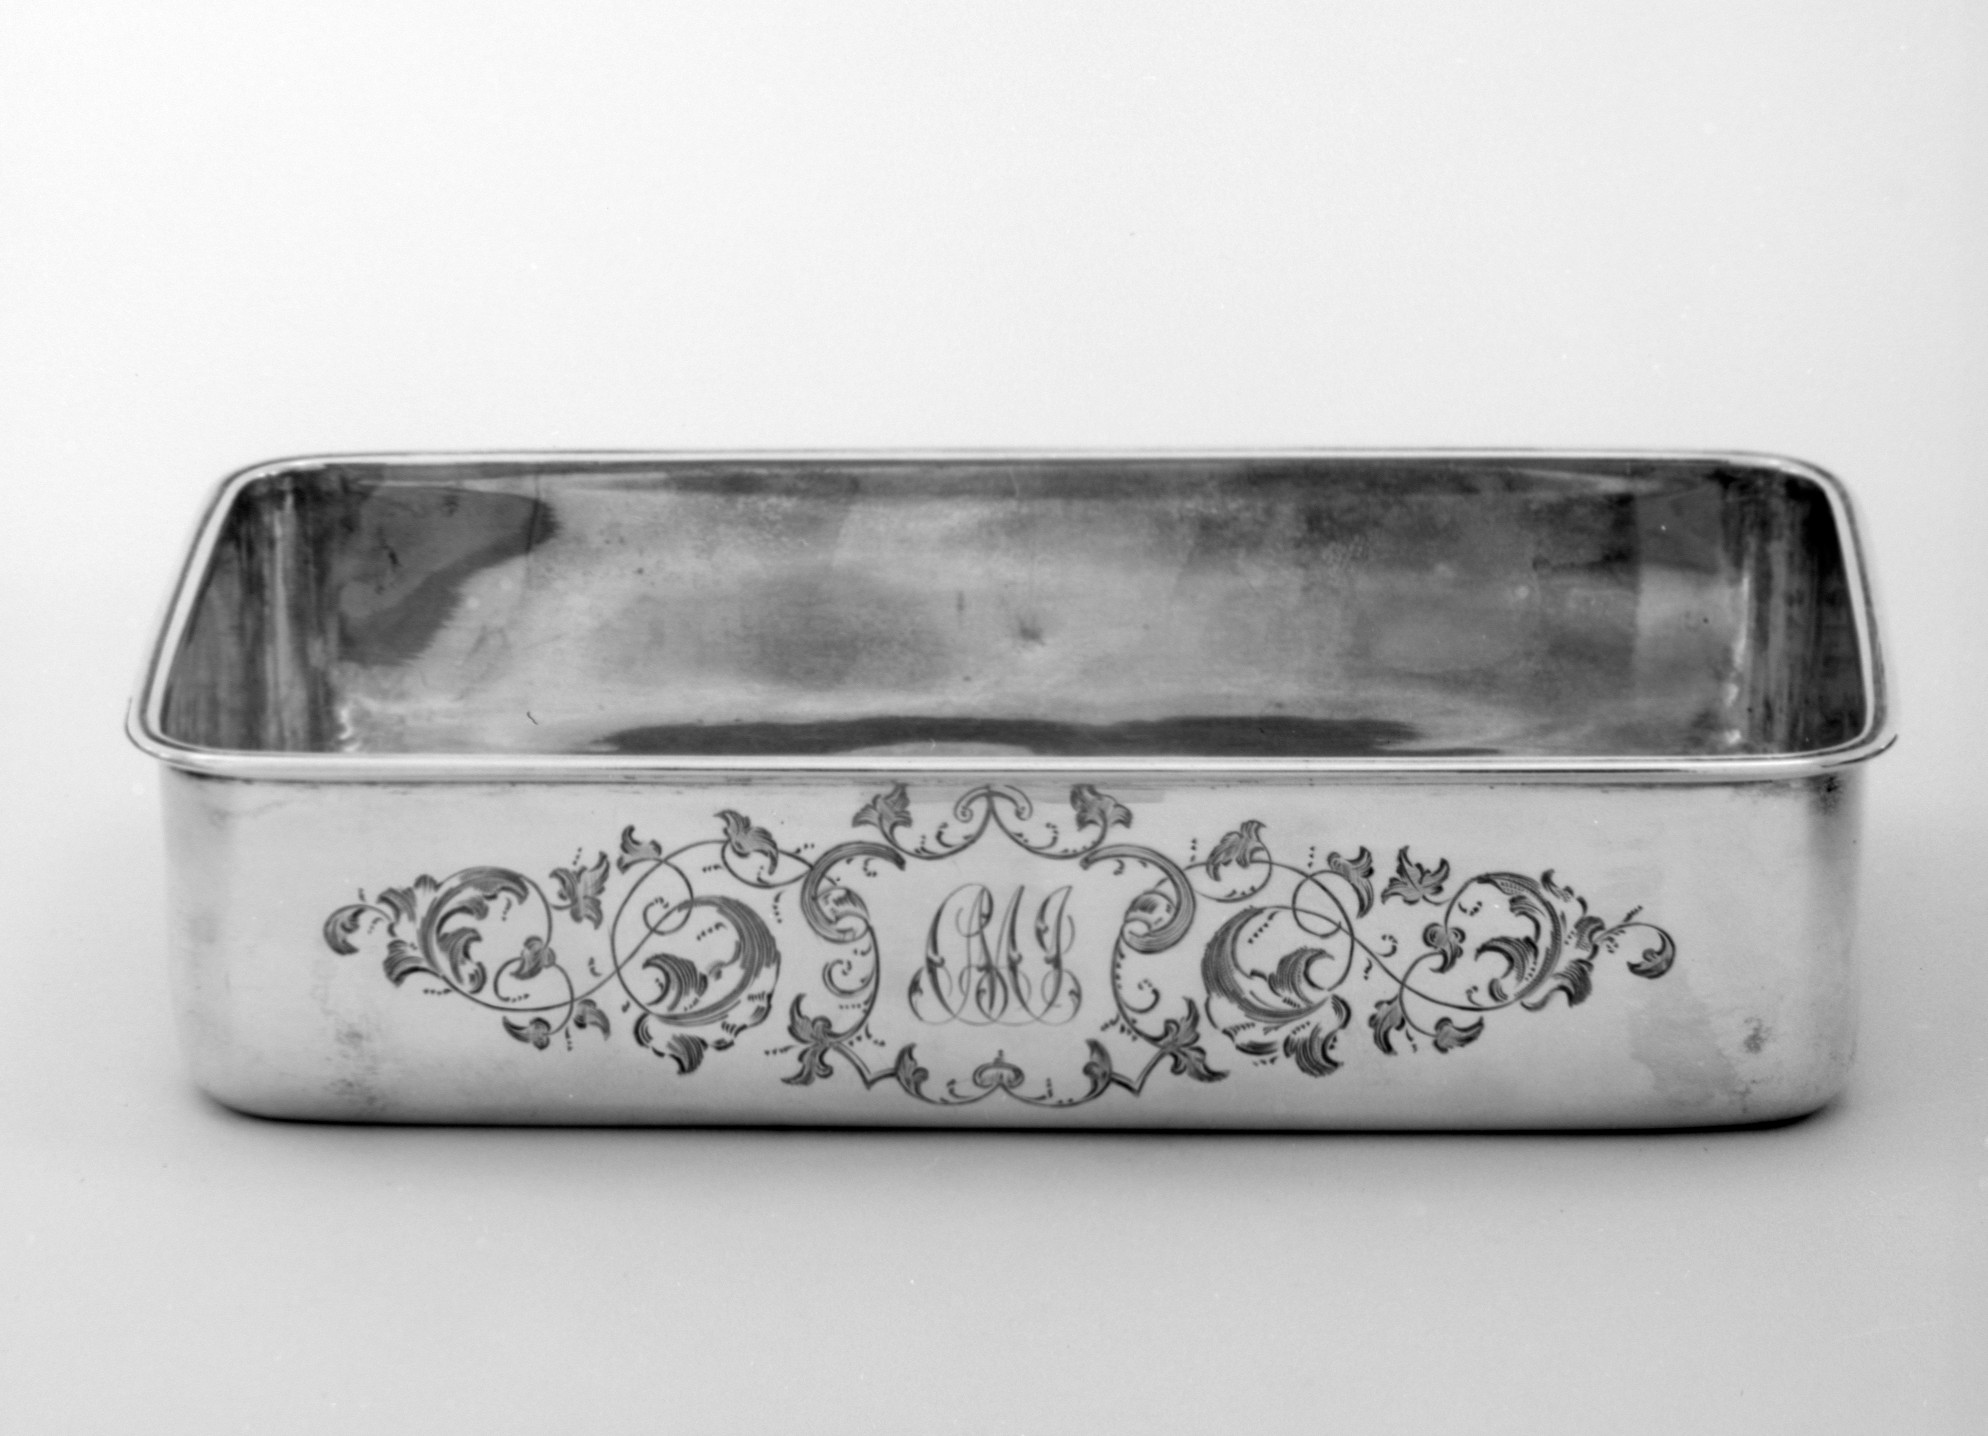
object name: basin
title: Basin (part of a set)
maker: anders lång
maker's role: maker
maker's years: 1843-1851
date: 1848-1849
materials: silver